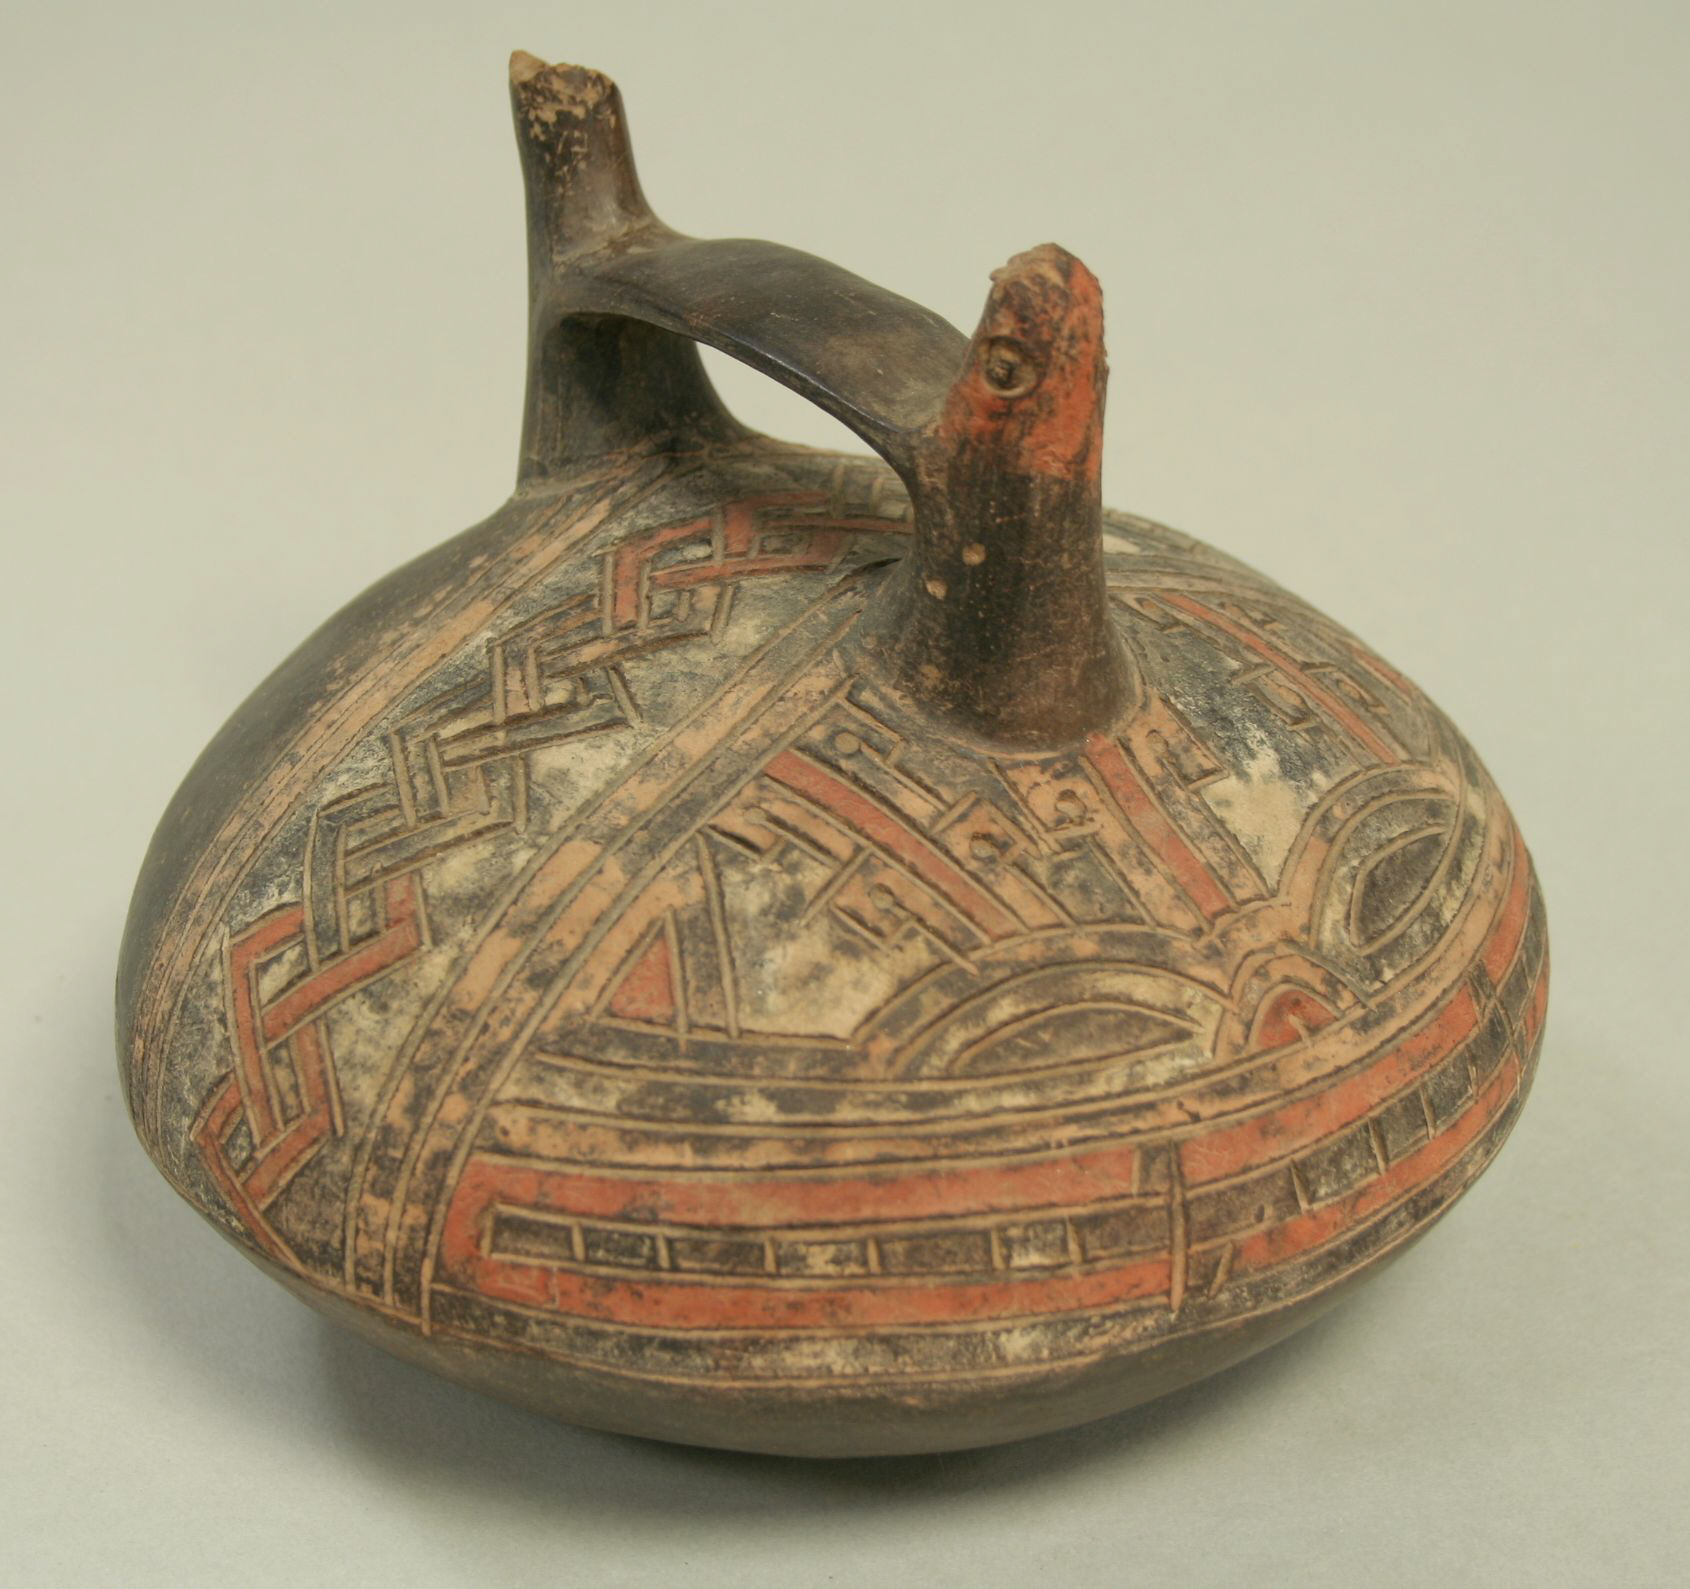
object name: bottle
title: Double Spout and Bridge Bottle with Feline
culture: paracas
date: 500-201 BCE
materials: ceramic, pigment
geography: peru